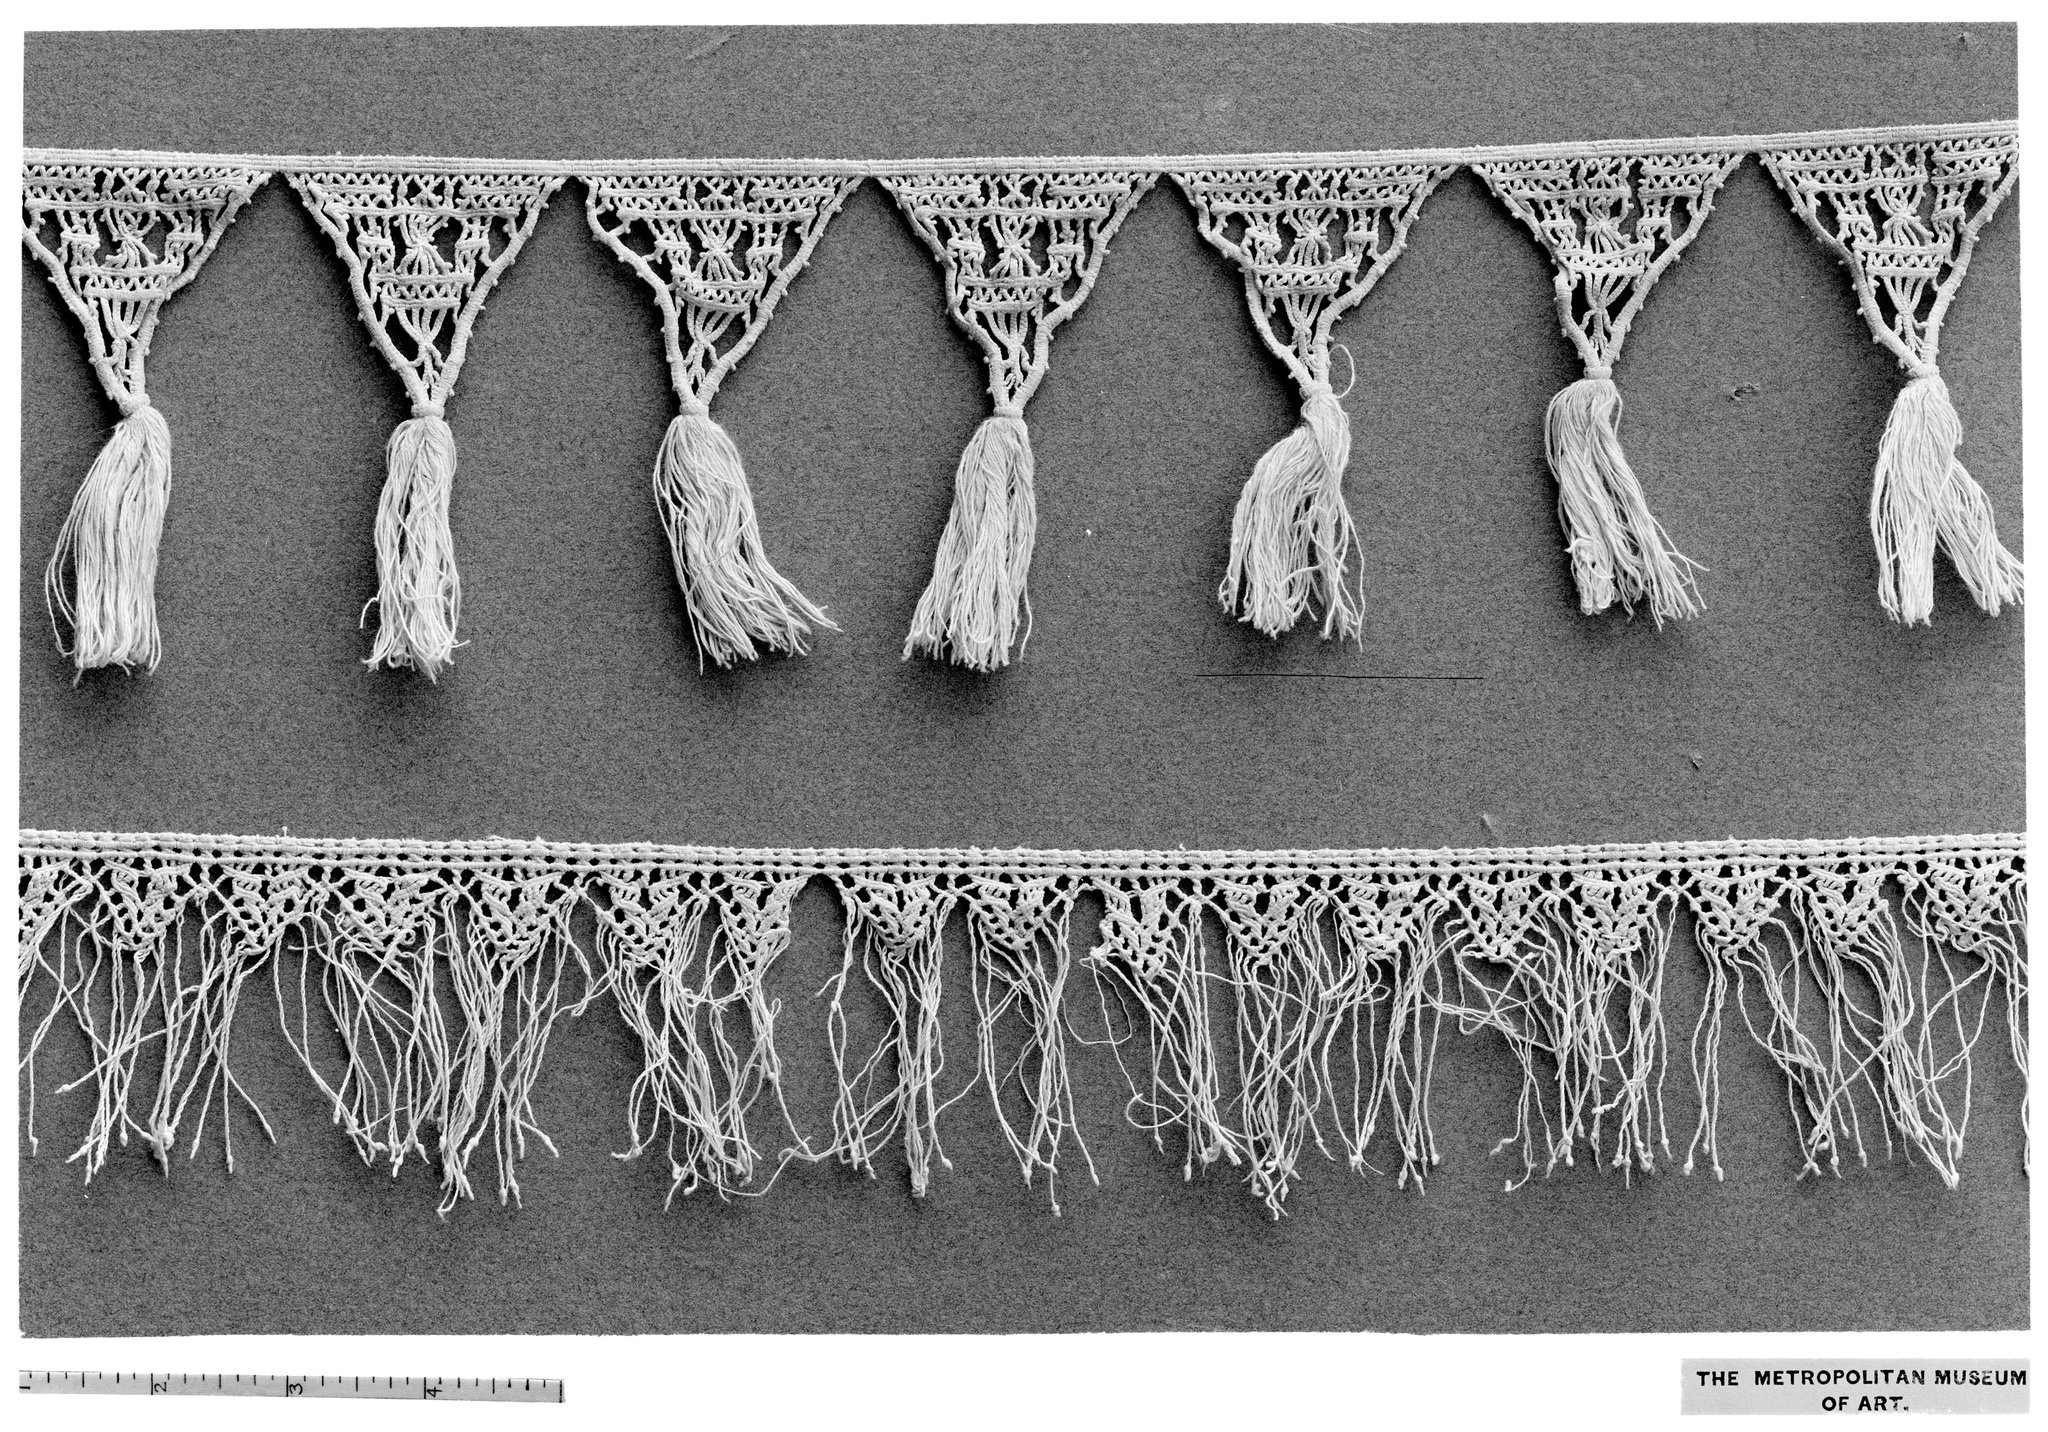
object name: edging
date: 1501-1600